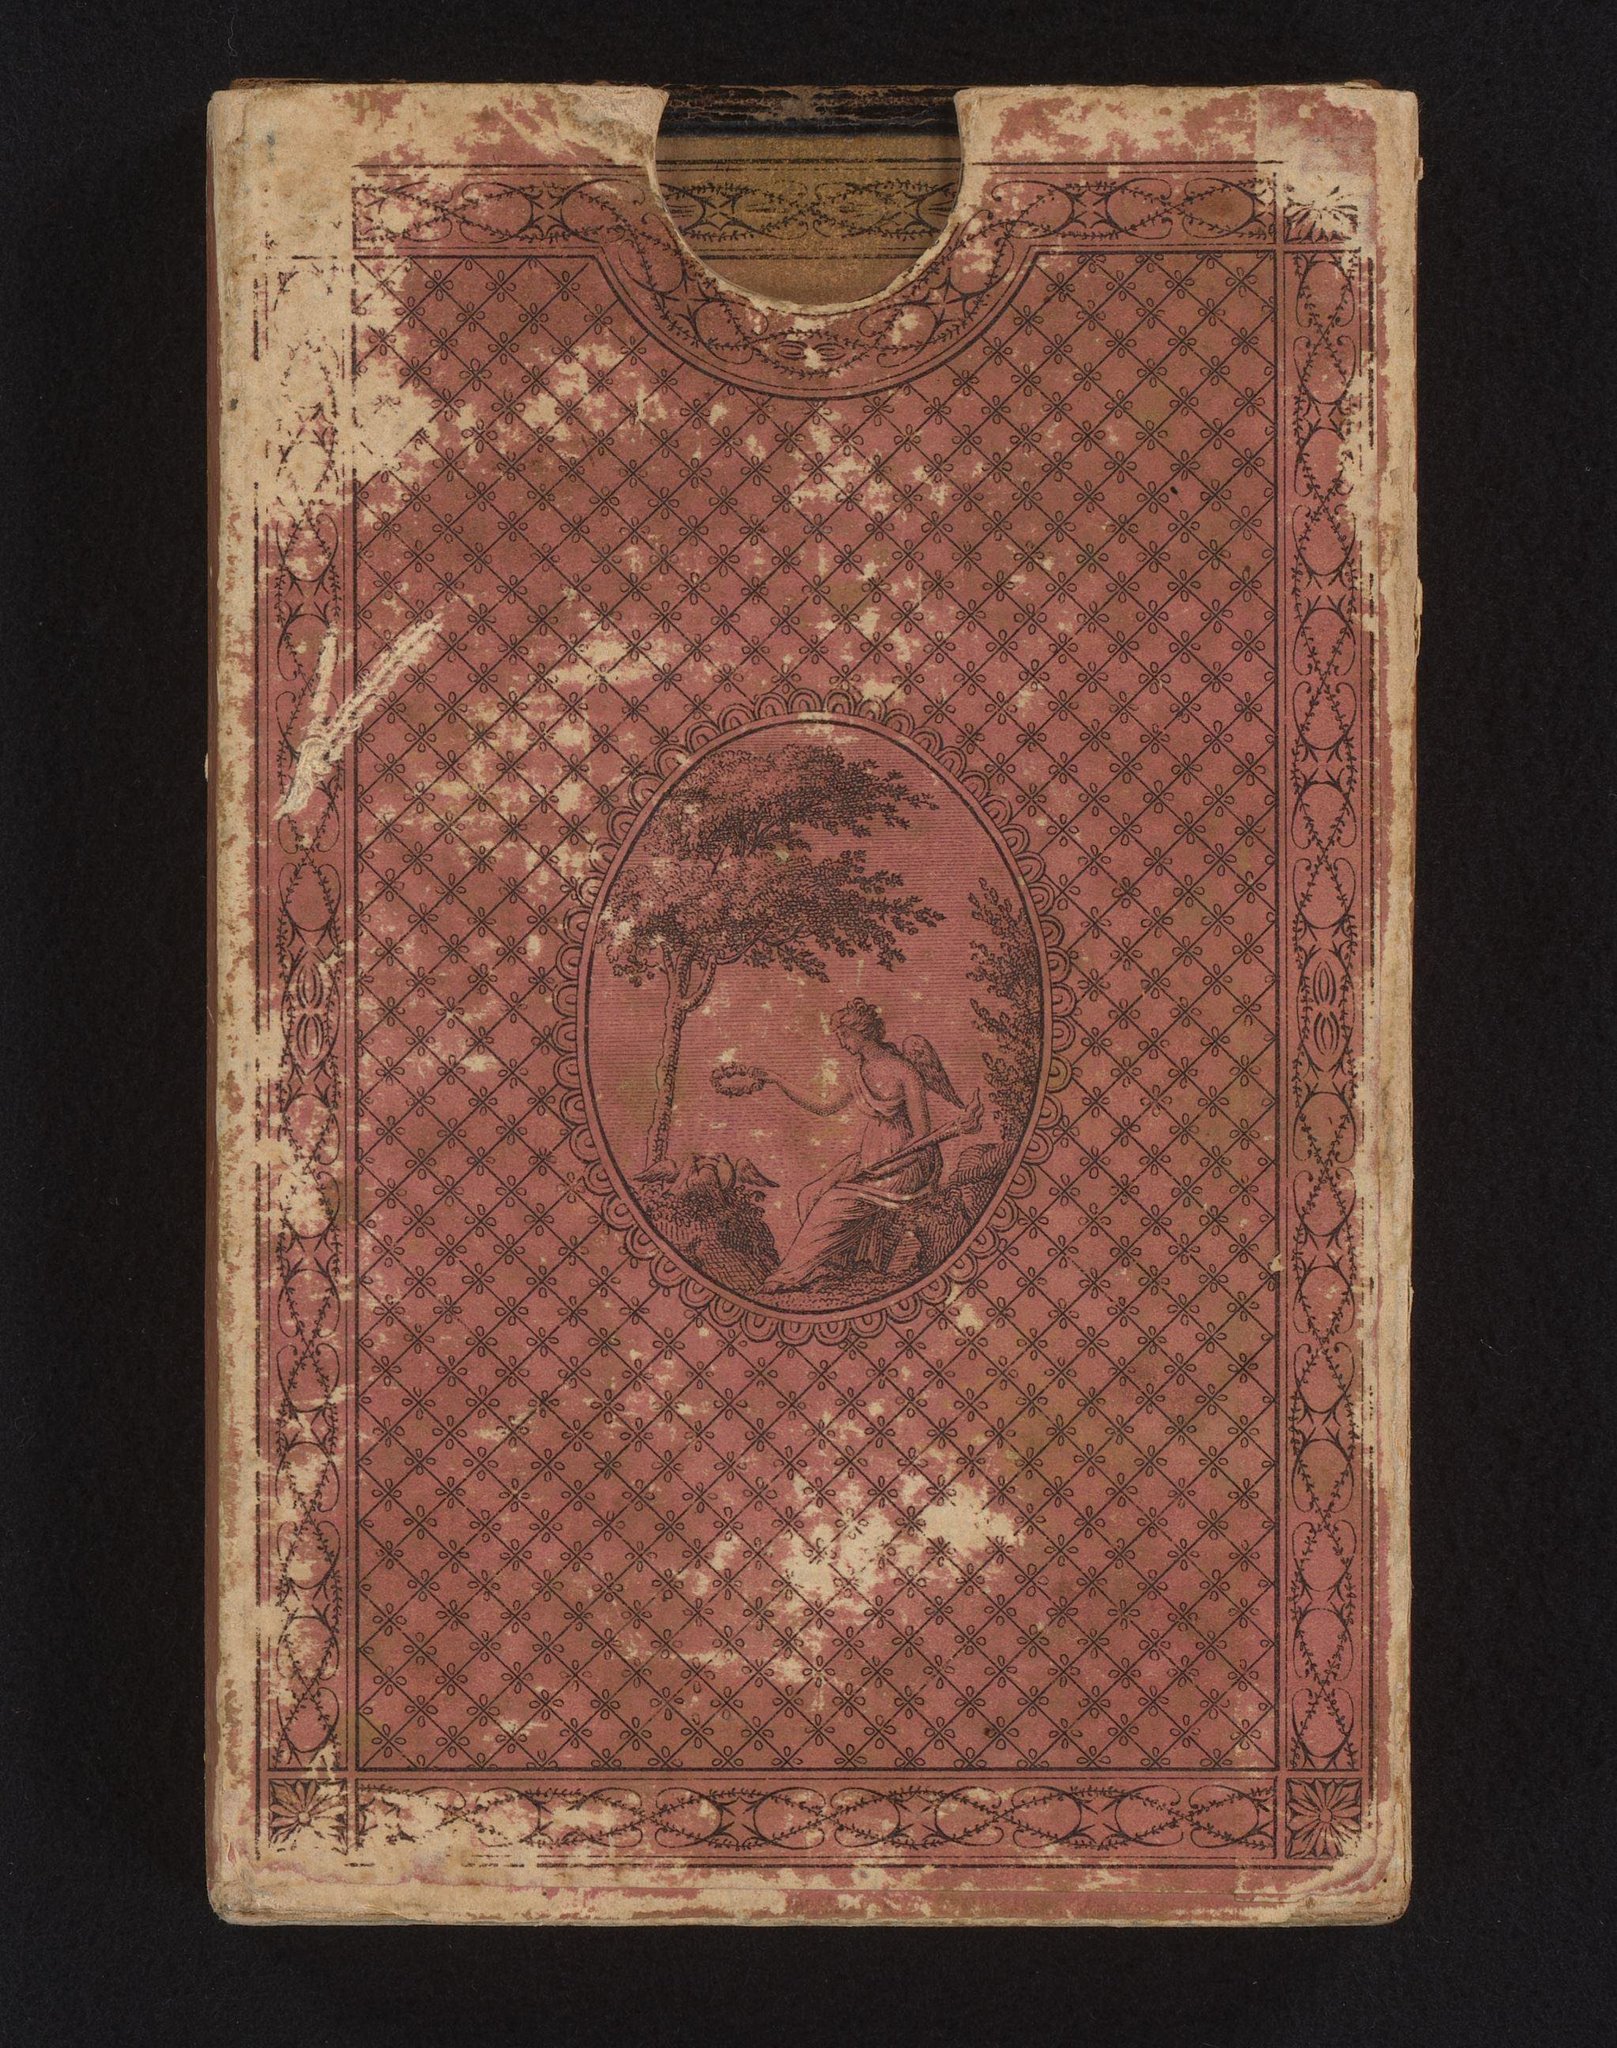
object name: cassette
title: Cassette voor een album amicorum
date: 1770-1826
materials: cardboard, paper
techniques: decorated paper, etching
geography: gottingen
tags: 'album amicorum', 'stammbuch', symbols, allegories of peace, 'pax'; 'pace' (ripa)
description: Deze cassette bevat een omslag (van een album amicorum) met 42 prenten. Bij alle prenten, op twee na, bevat het verso een opdracht, persoonlijk handgeschreven tekst en/of tekening. De casette, omslag en prenten zijn mogelijk als geheel uitgegeven door Johann Carl Wiederhold in Göttingen.